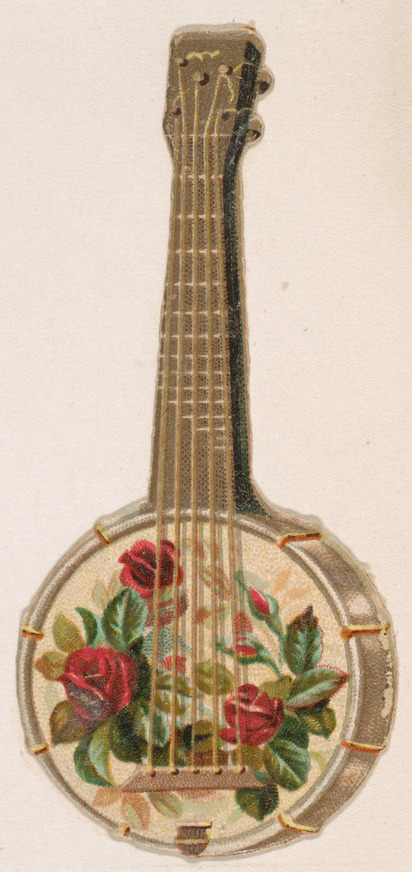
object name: print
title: Banjo, from the Novelties series (N228, Type 4) issued by Kinney Bros.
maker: kinney brothers tobacco company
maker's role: publisher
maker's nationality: american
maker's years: 1869-2011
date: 1889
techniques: color lithograph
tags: musical instruments,roses